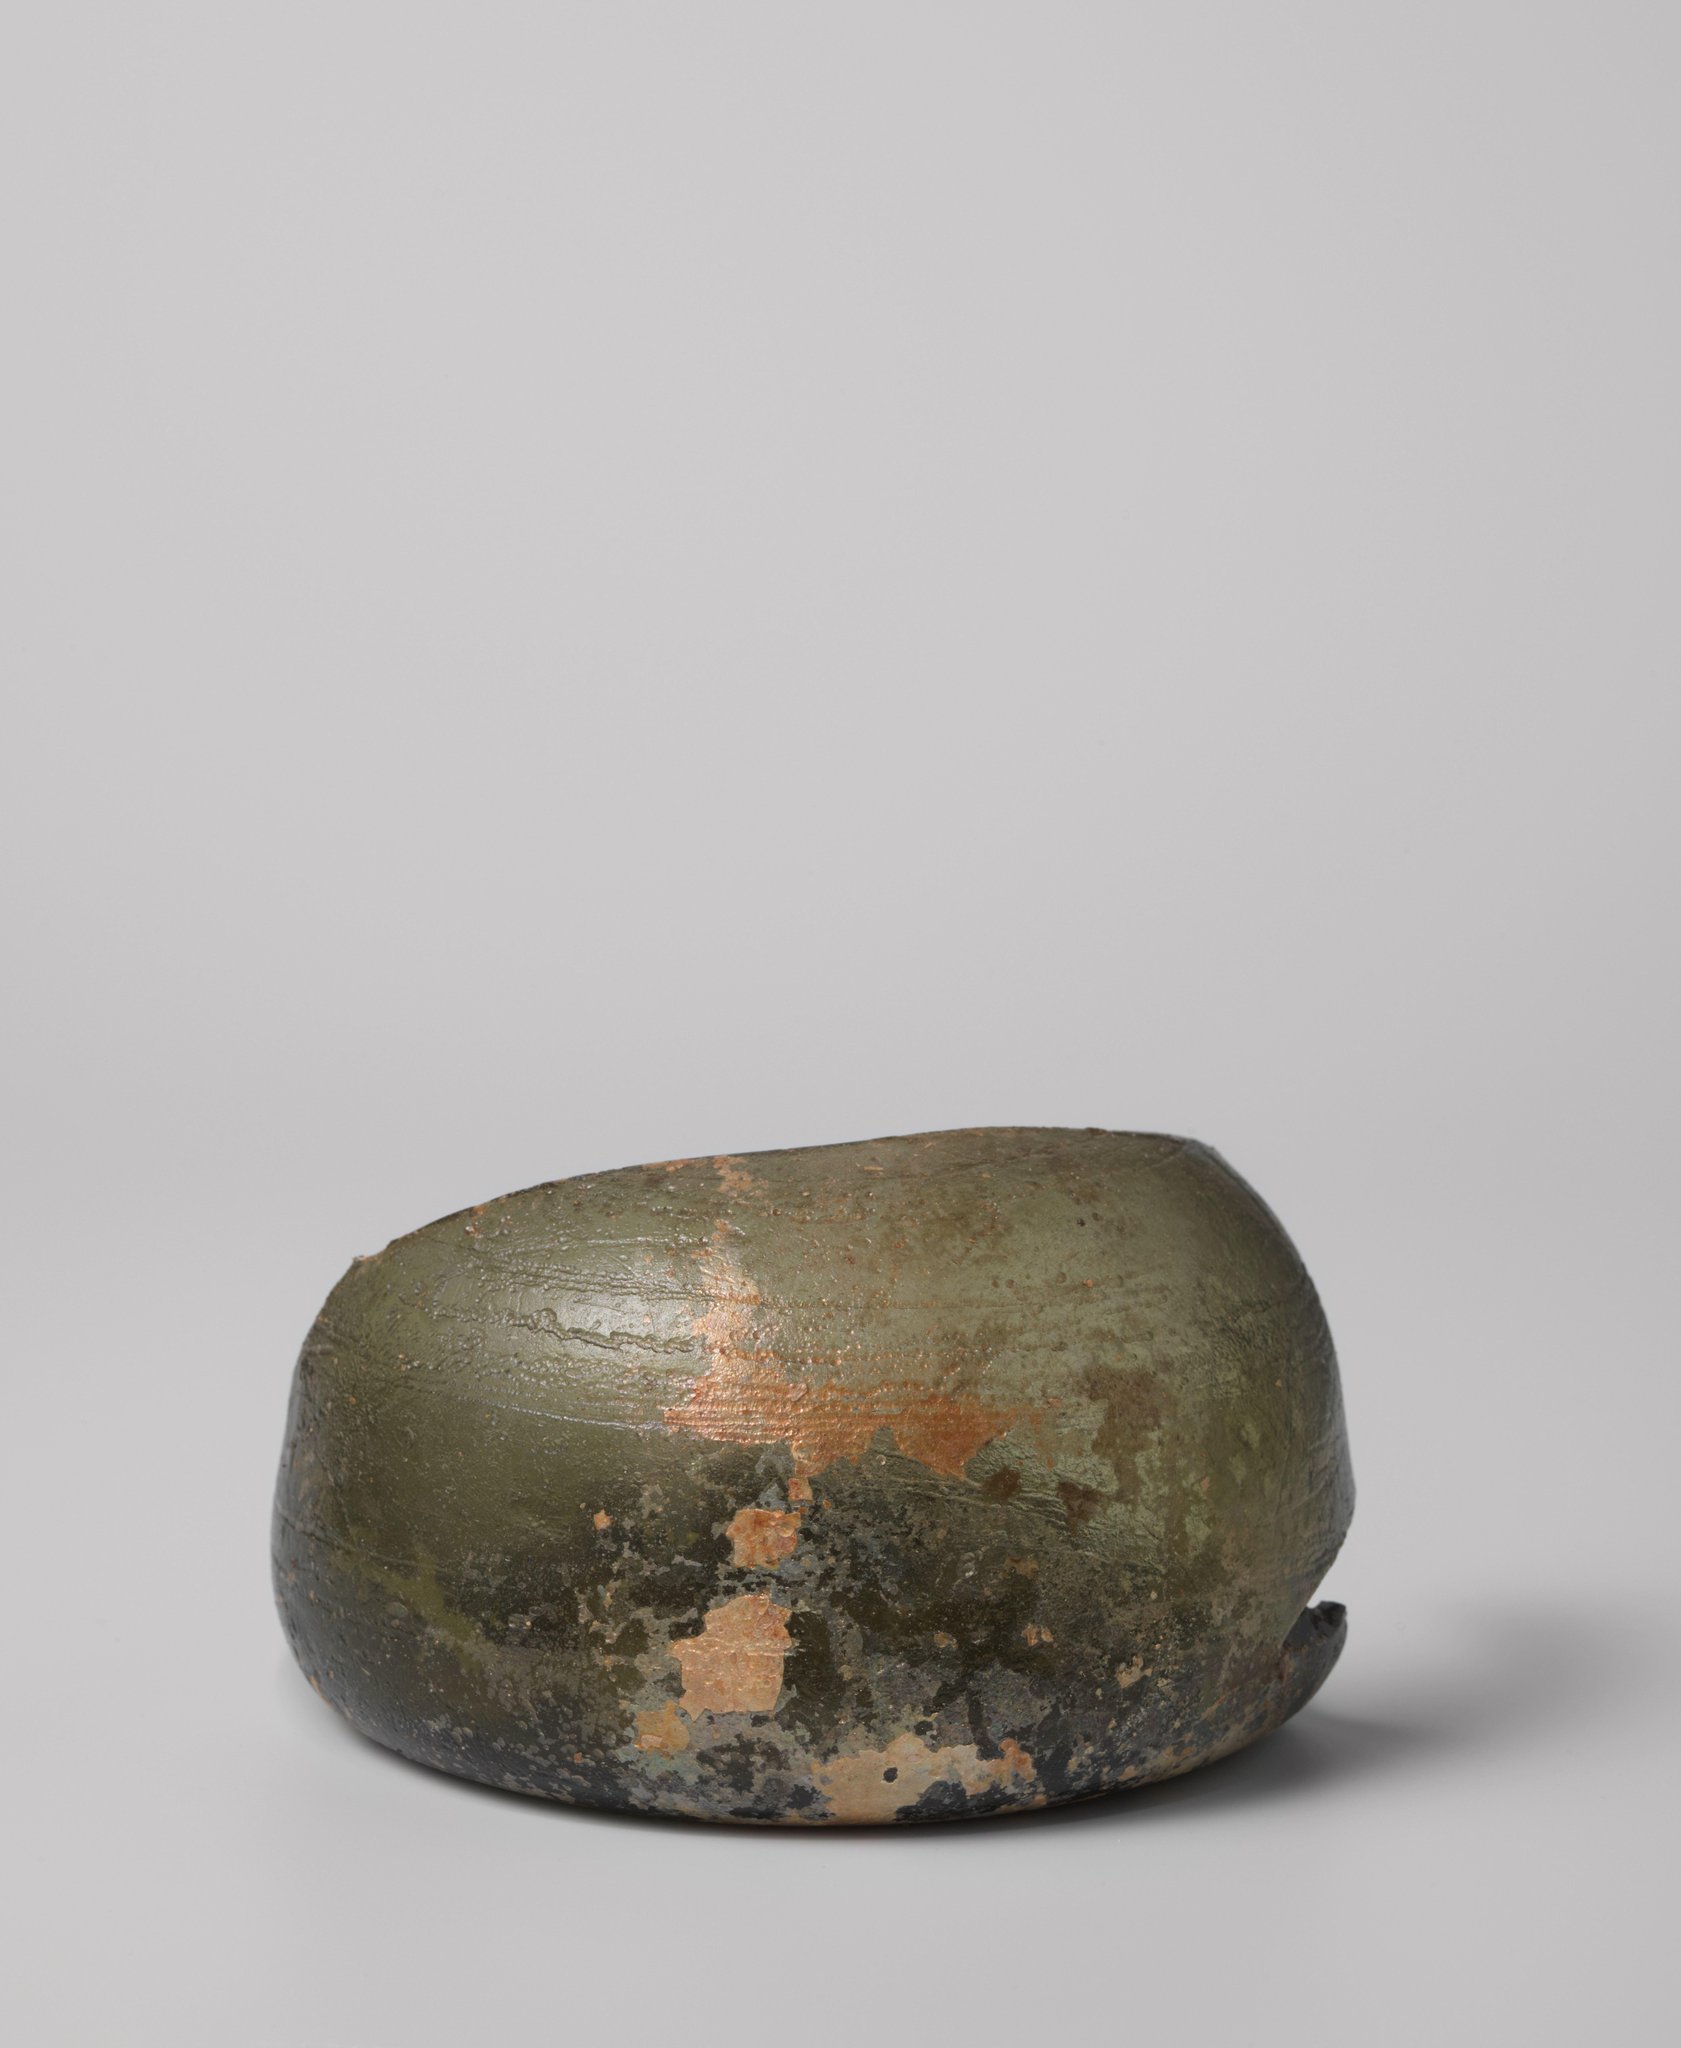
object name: wine bottle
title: Buik van een wijnfles uit het wrak van de Oost-Indiëvaarder Hollandia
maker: Anonymous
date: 1700-1743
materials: glass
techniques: green glass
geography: netherlands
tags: verenigde oostindische compagnie, hollandia (schip), annet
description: Incomplete wijnfles. Wine bottle, continental production, body, with vertical side; (1) eroded (7.5h, belly 14d, base 11d), tcs-kick-up.